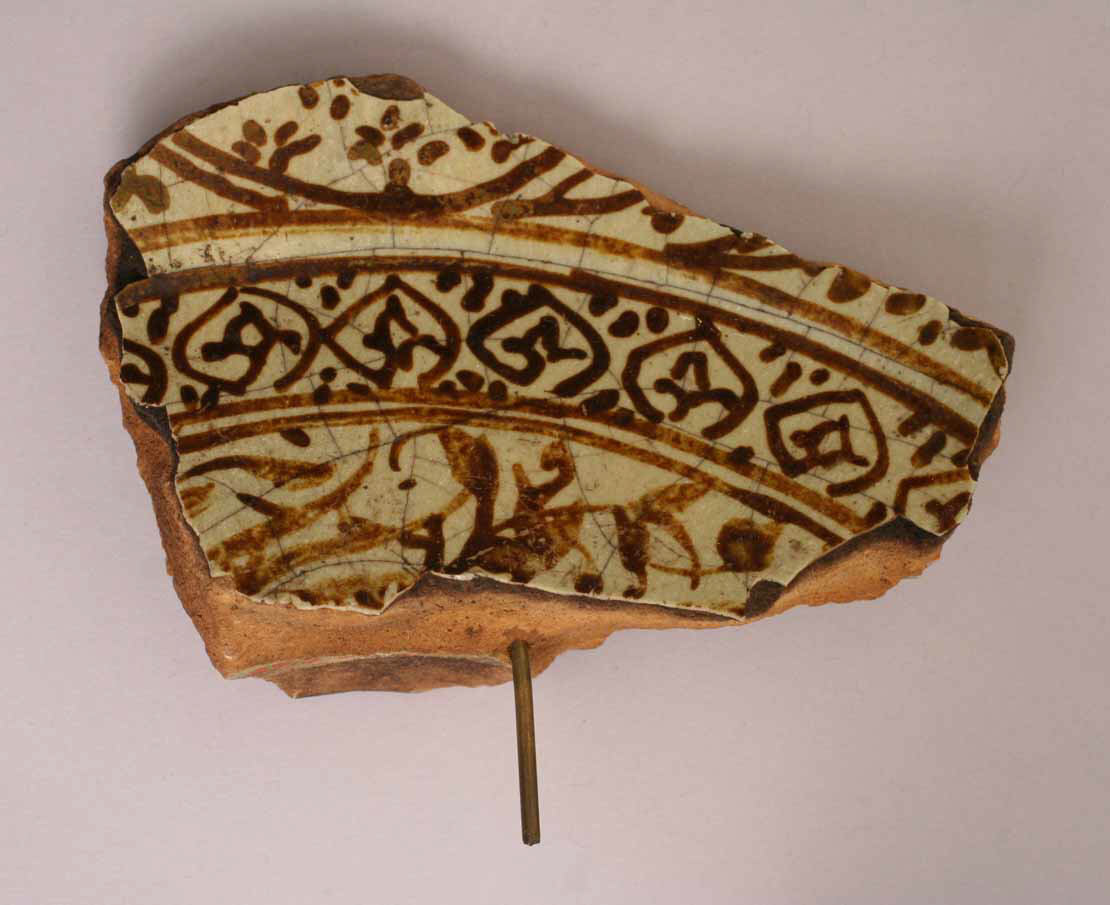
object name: fragment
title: Ceramic Fragment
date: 1201-1400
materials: earthenware, glaze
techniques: coloring, incising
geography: egypt